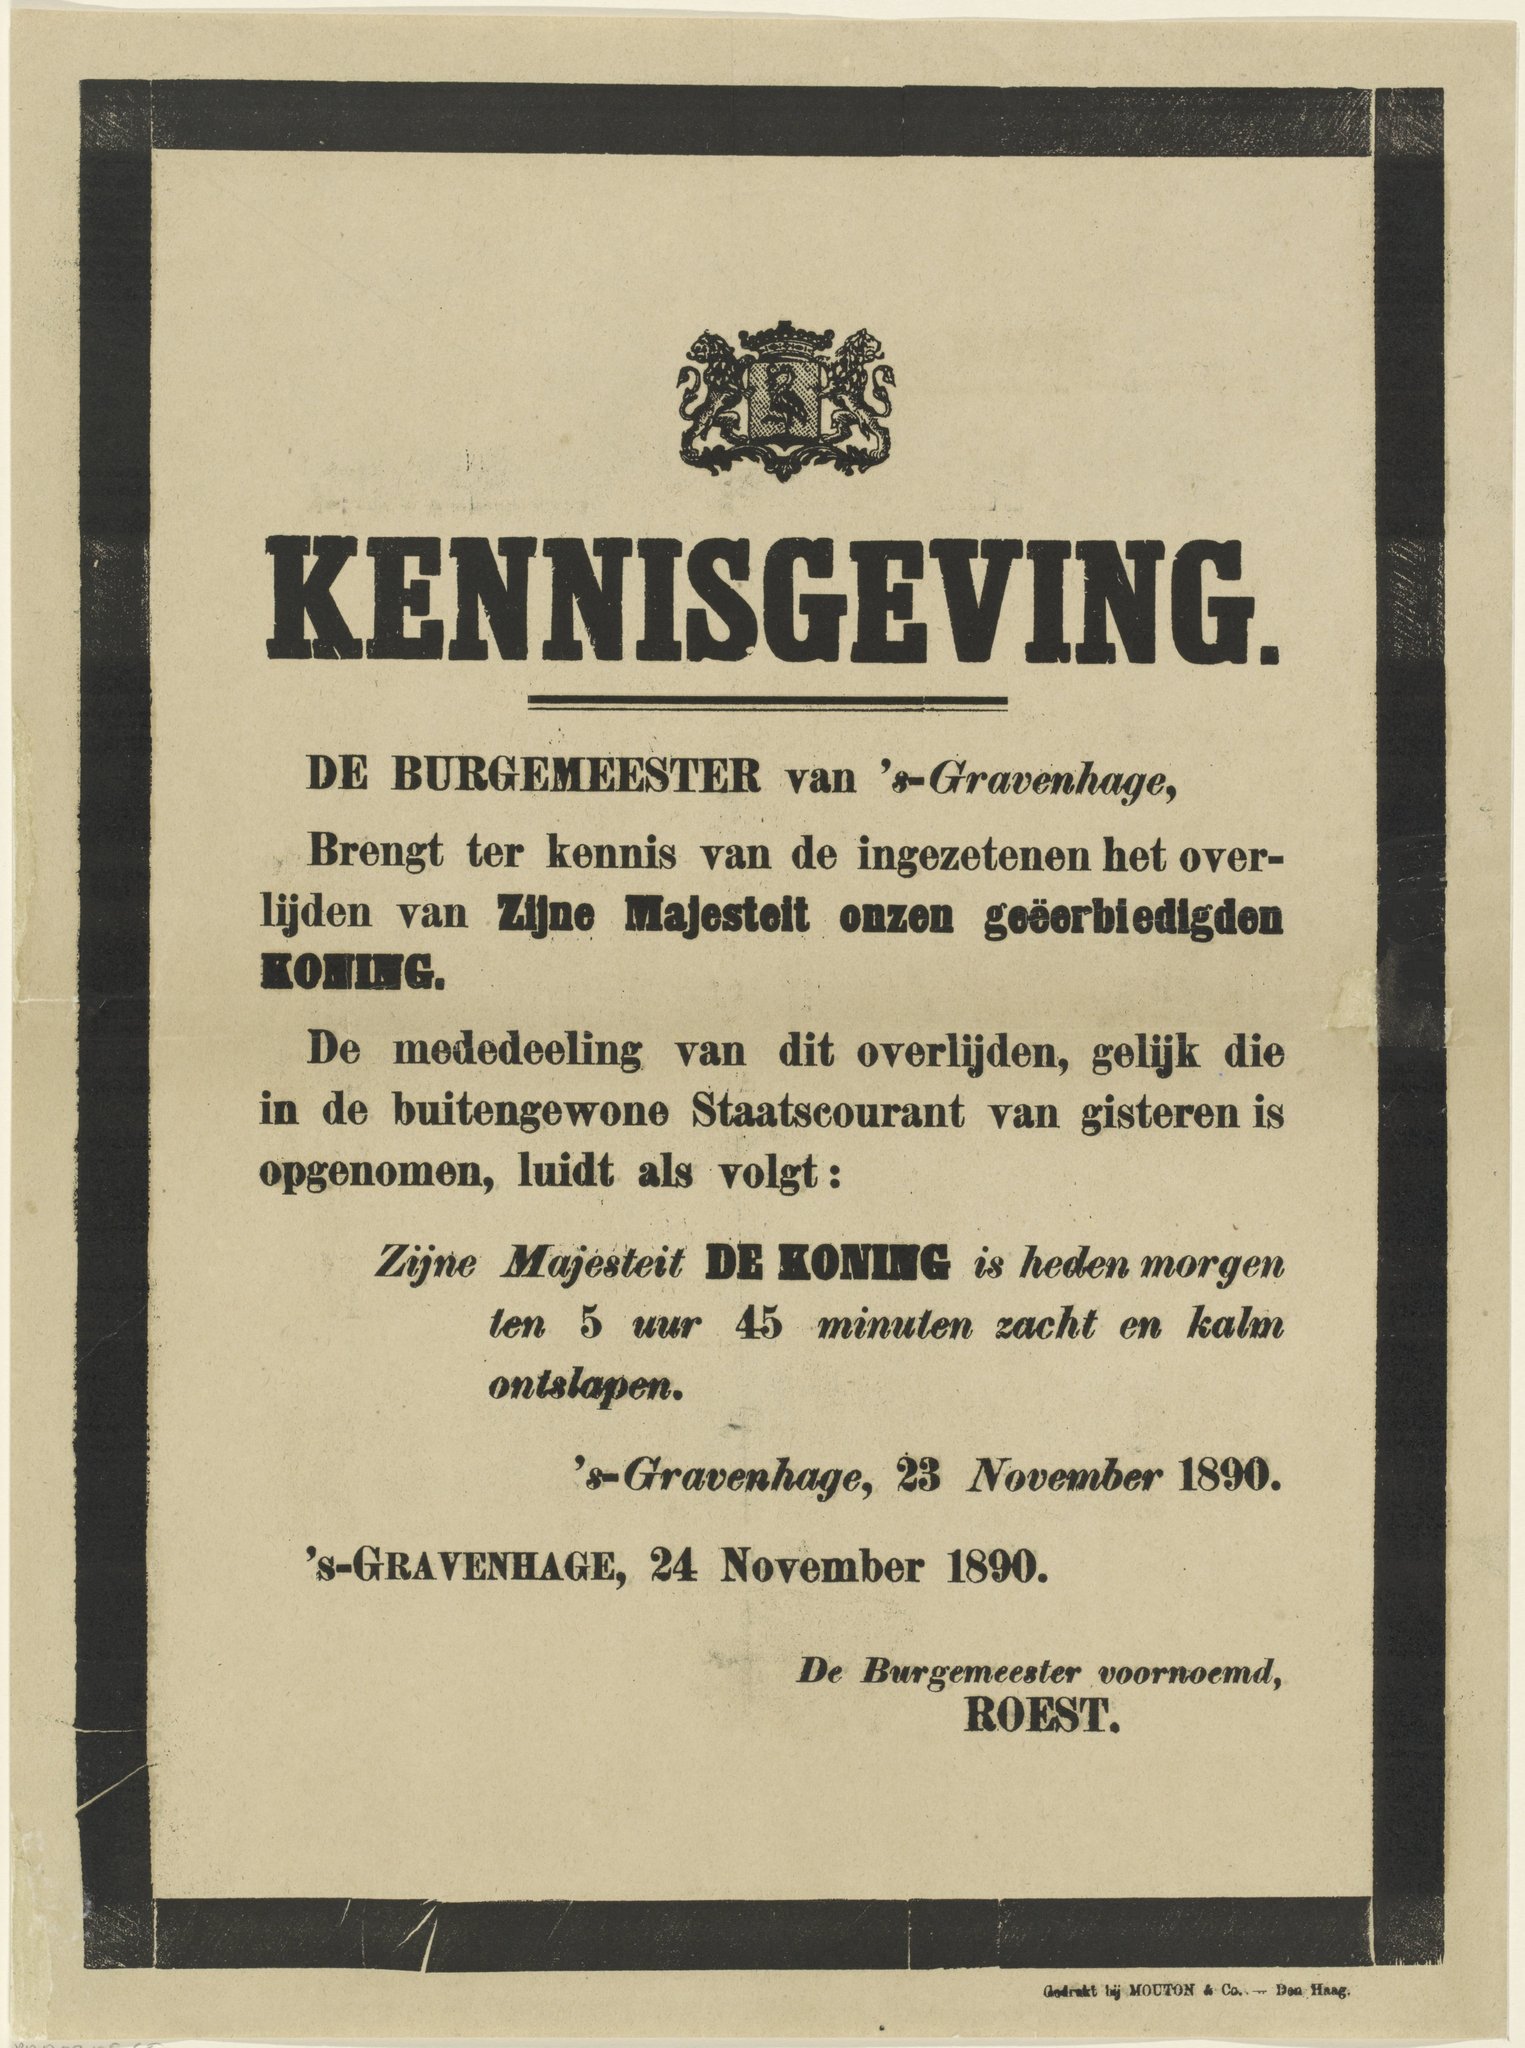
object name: text sheet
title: Kennisgeving van het overlijden van Willem III, koning der Nederlanden, op 23 november 1890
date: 1890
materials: paper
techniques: letterpress printing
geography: the hague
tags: brussels, willem iii (koning der nederlanden)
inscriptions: date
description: Kennisgeving van het overlijden van Willem III in Paleis Noordeinde te Den Haag op 23 november 1890.